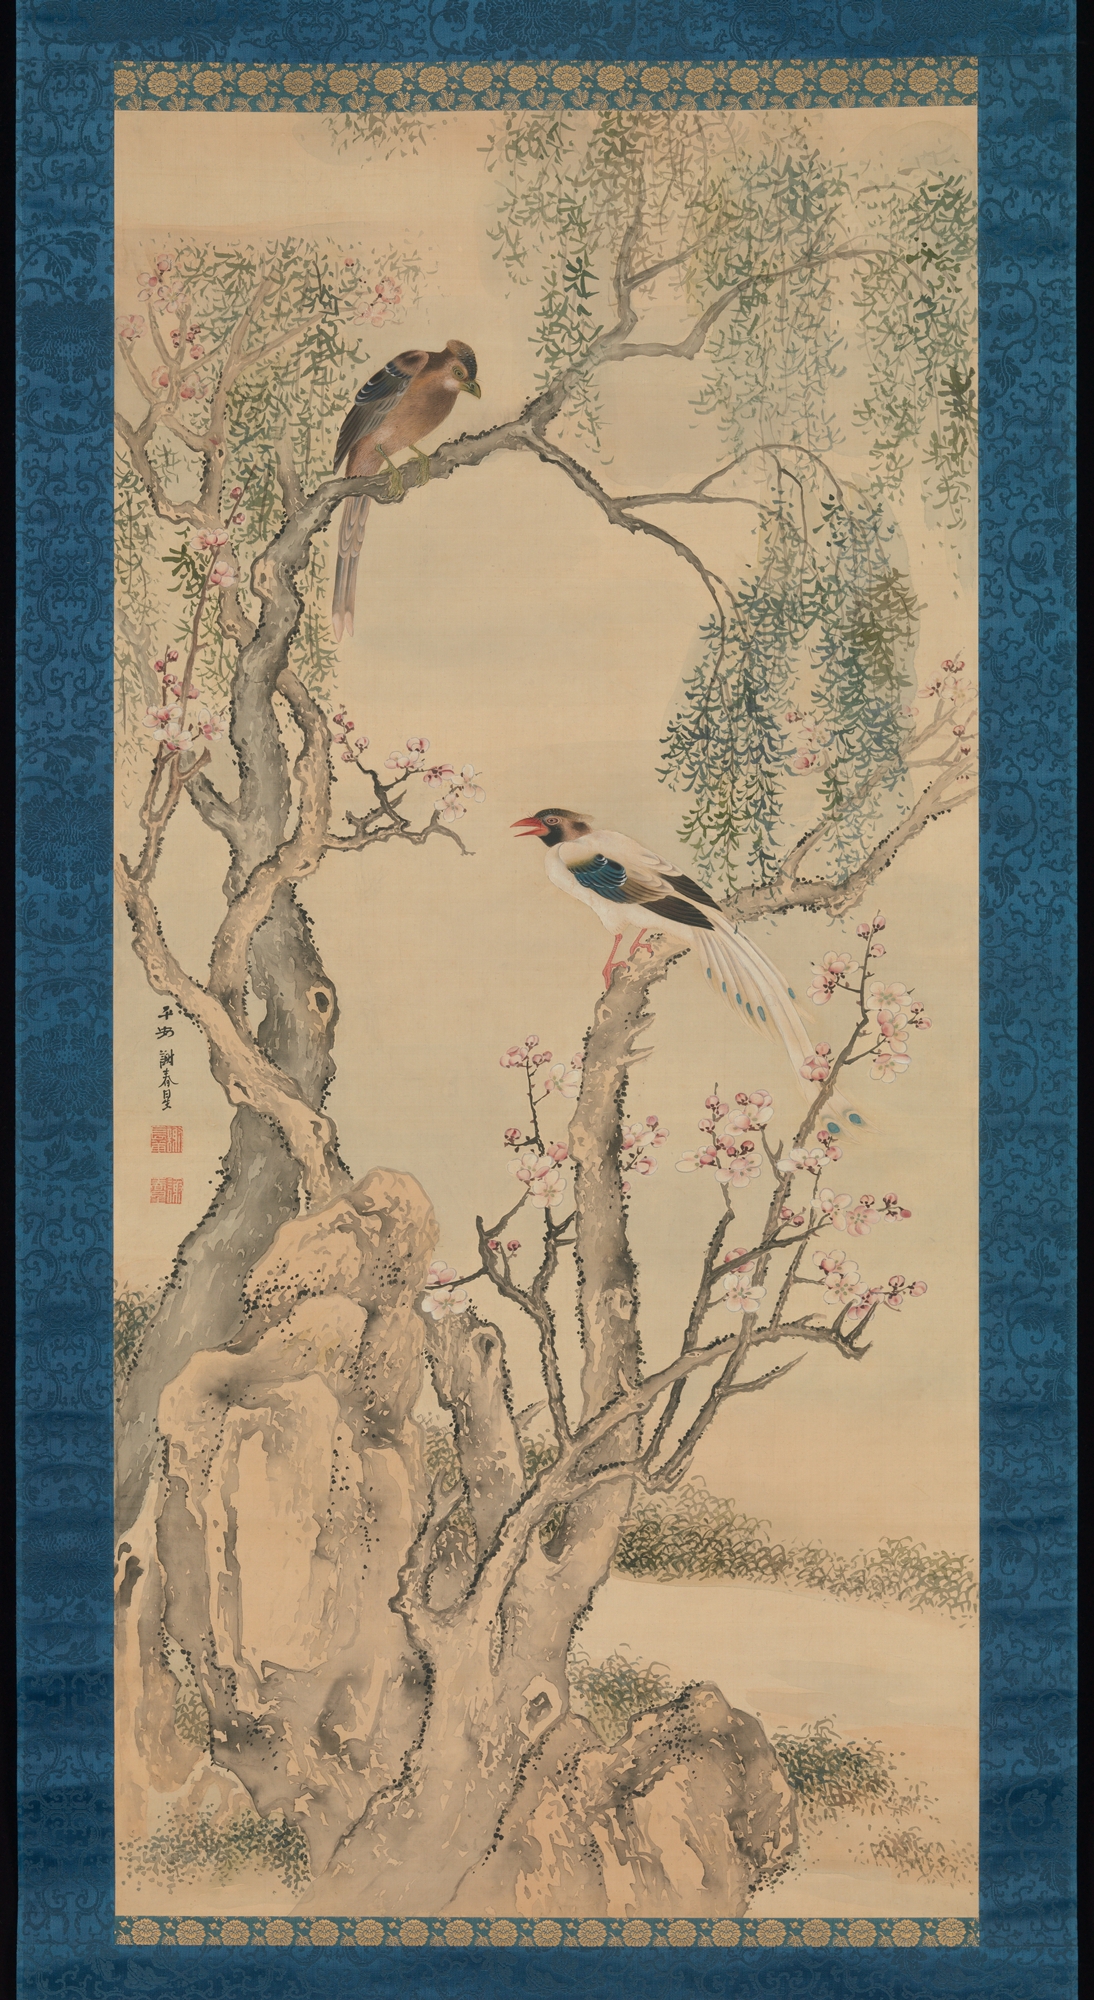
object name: hanging scroll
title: Birds in Willows and Blossoming Peach Tree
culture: japanese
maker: yosa buson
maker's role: artist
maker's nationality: japanese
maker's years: 1716-1783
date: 1760-1769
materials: ink, silk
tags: birds,trees